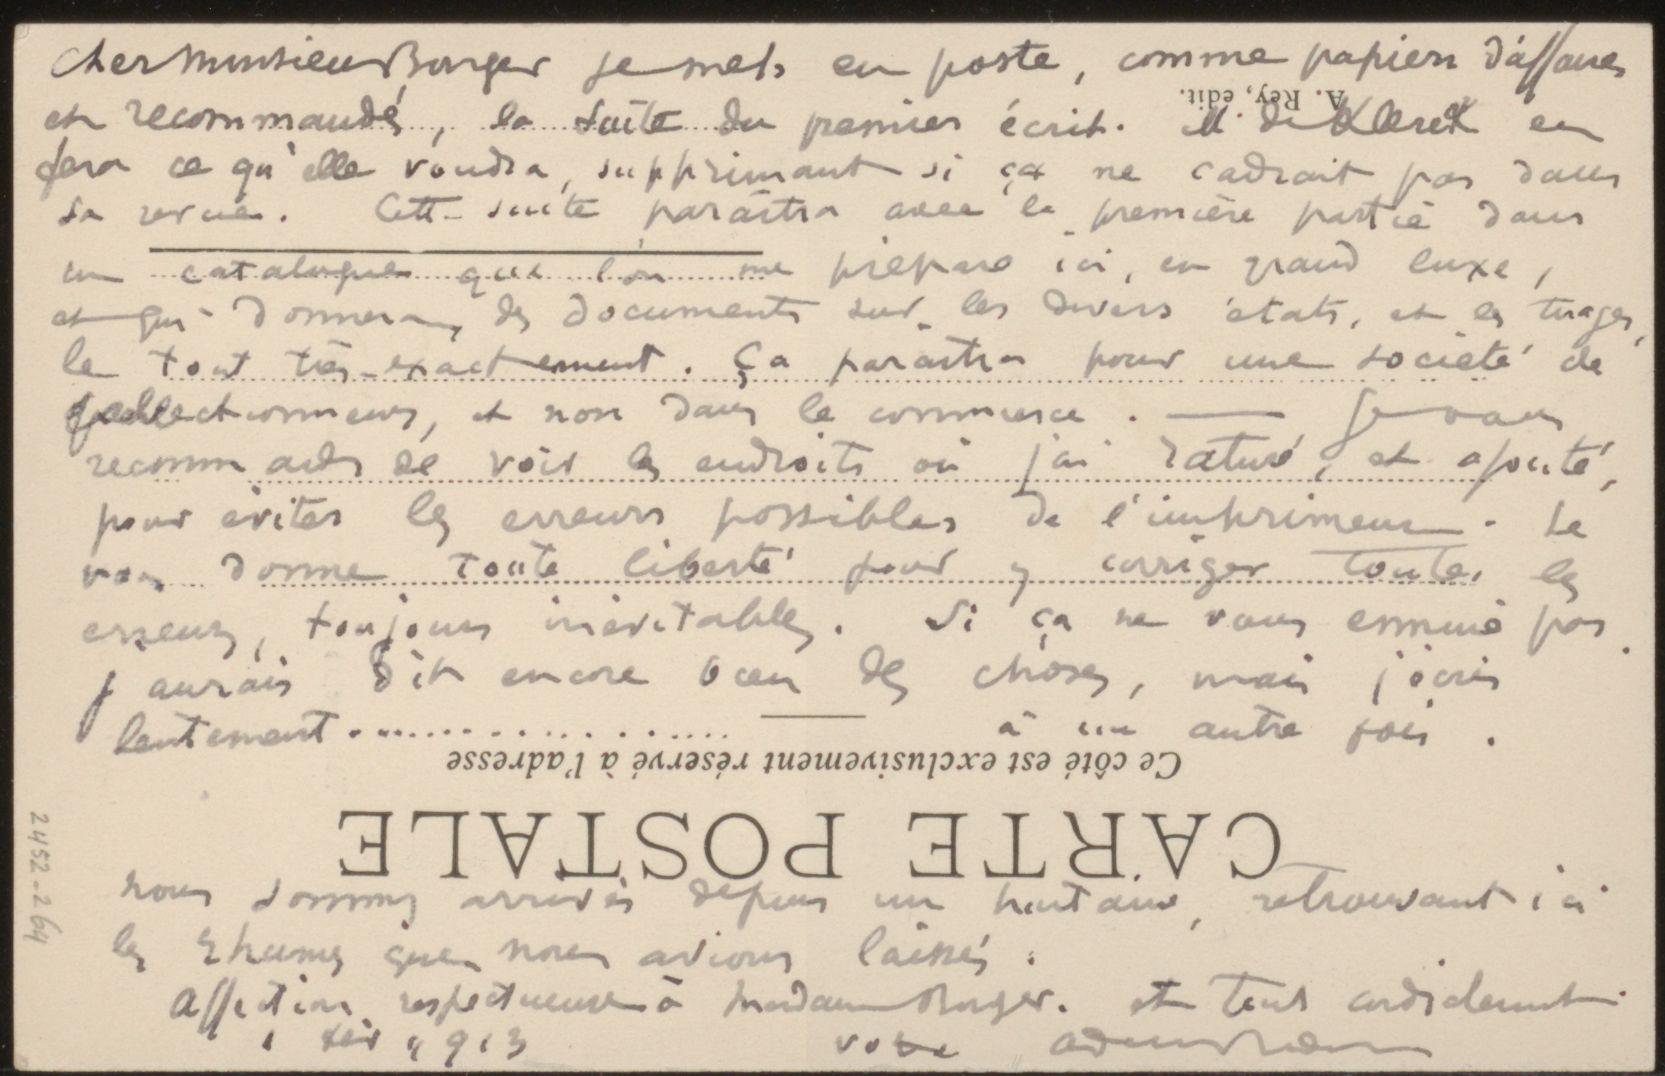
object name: ansichtkaart, prentbriefkaart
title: Prentbriefkaart aan Andries Bonger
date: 1913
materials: cardboard, ink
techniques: photograph, pen, writing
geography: paris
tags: amsterdam, andries bonger